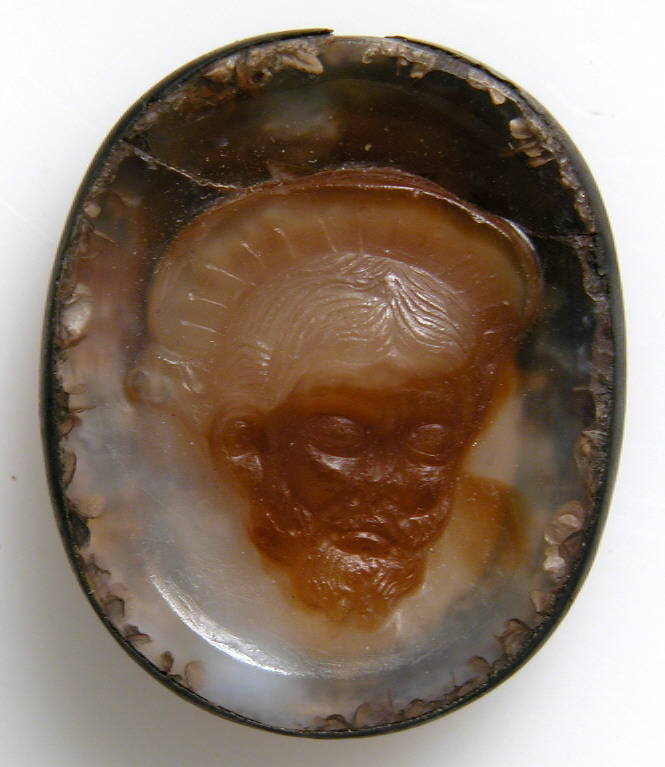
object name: cameo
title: Cameo with Saint John The Baptist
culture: italian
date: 1401-1500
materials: gemstone, silver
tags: saint john the baptist